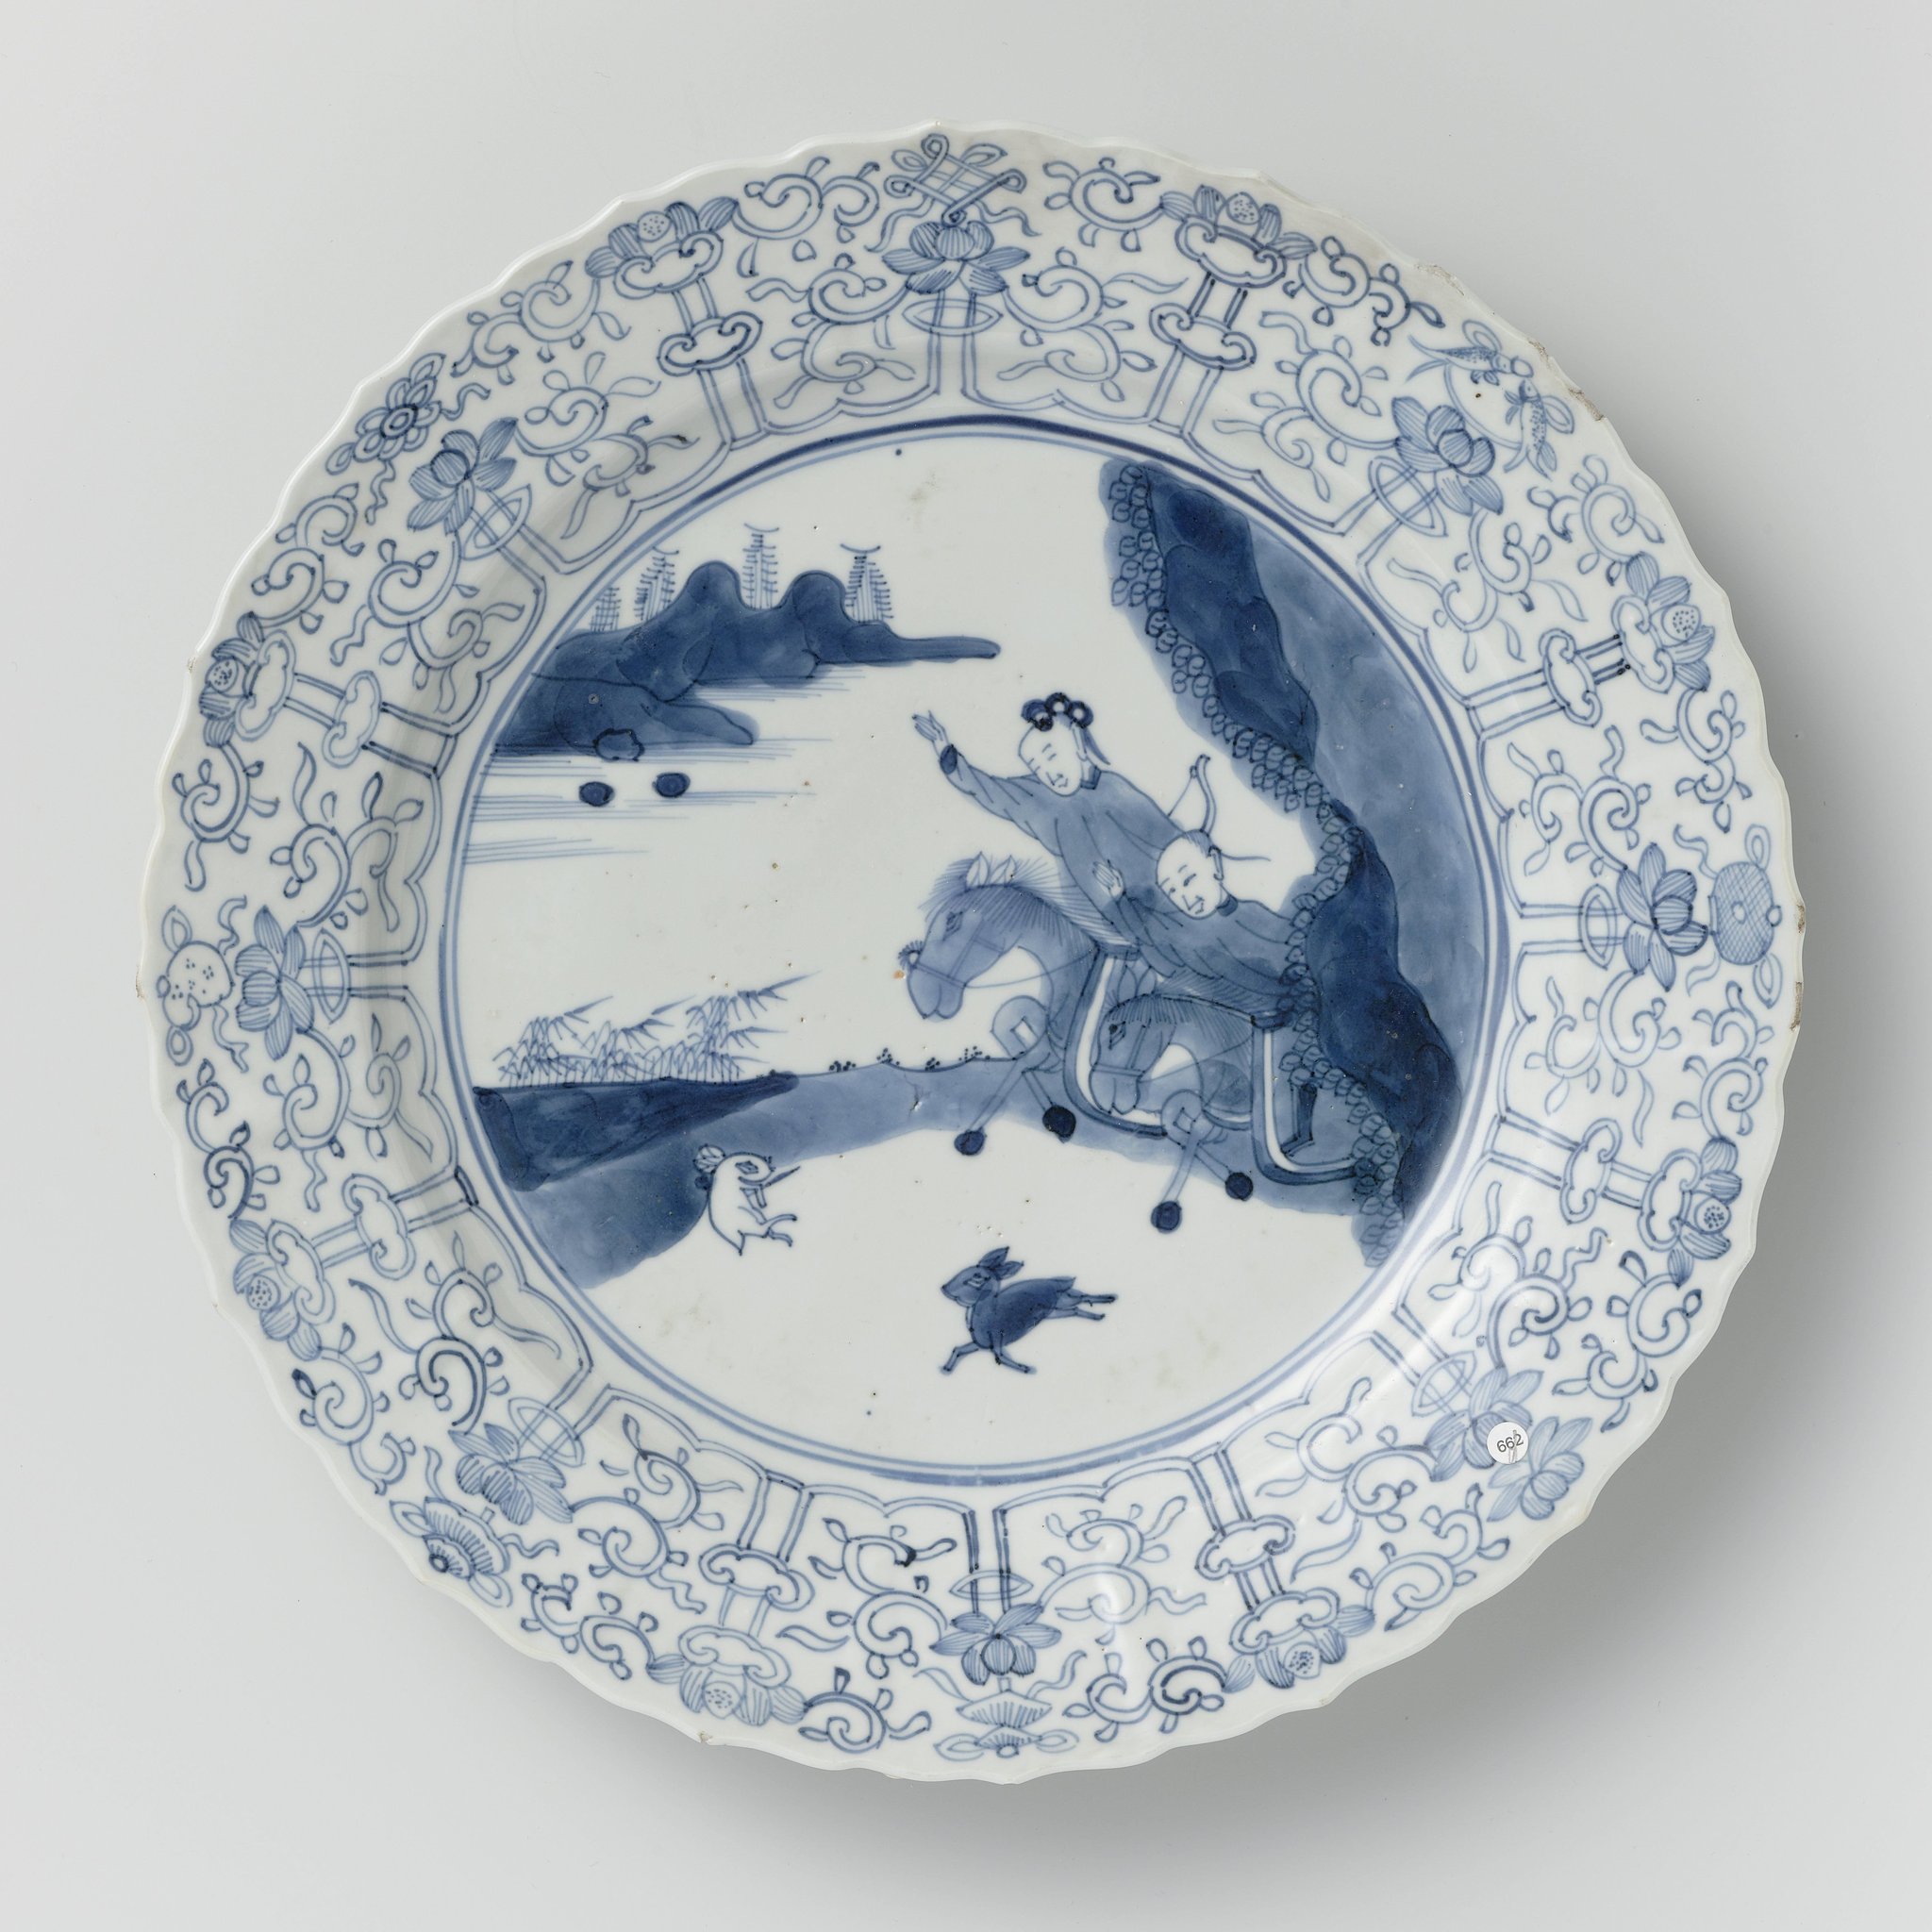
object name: platter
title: Saucer-dish with hunting scene, lotus scrolls and auspicious symbols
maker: Anonymous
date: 1700-1724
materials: cobalt, glaze, paint, porcelain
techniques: firing, forming, turning, vitrification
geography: china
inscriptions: mark: ‘大 明 成 化 年 製 dà míng Chéng huà nián zhì’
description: Bord, op plat de"konijnenjacht", de gekartelde en licht gewelfde rand met gestileerde lotusbloemen en lijnmotieven.